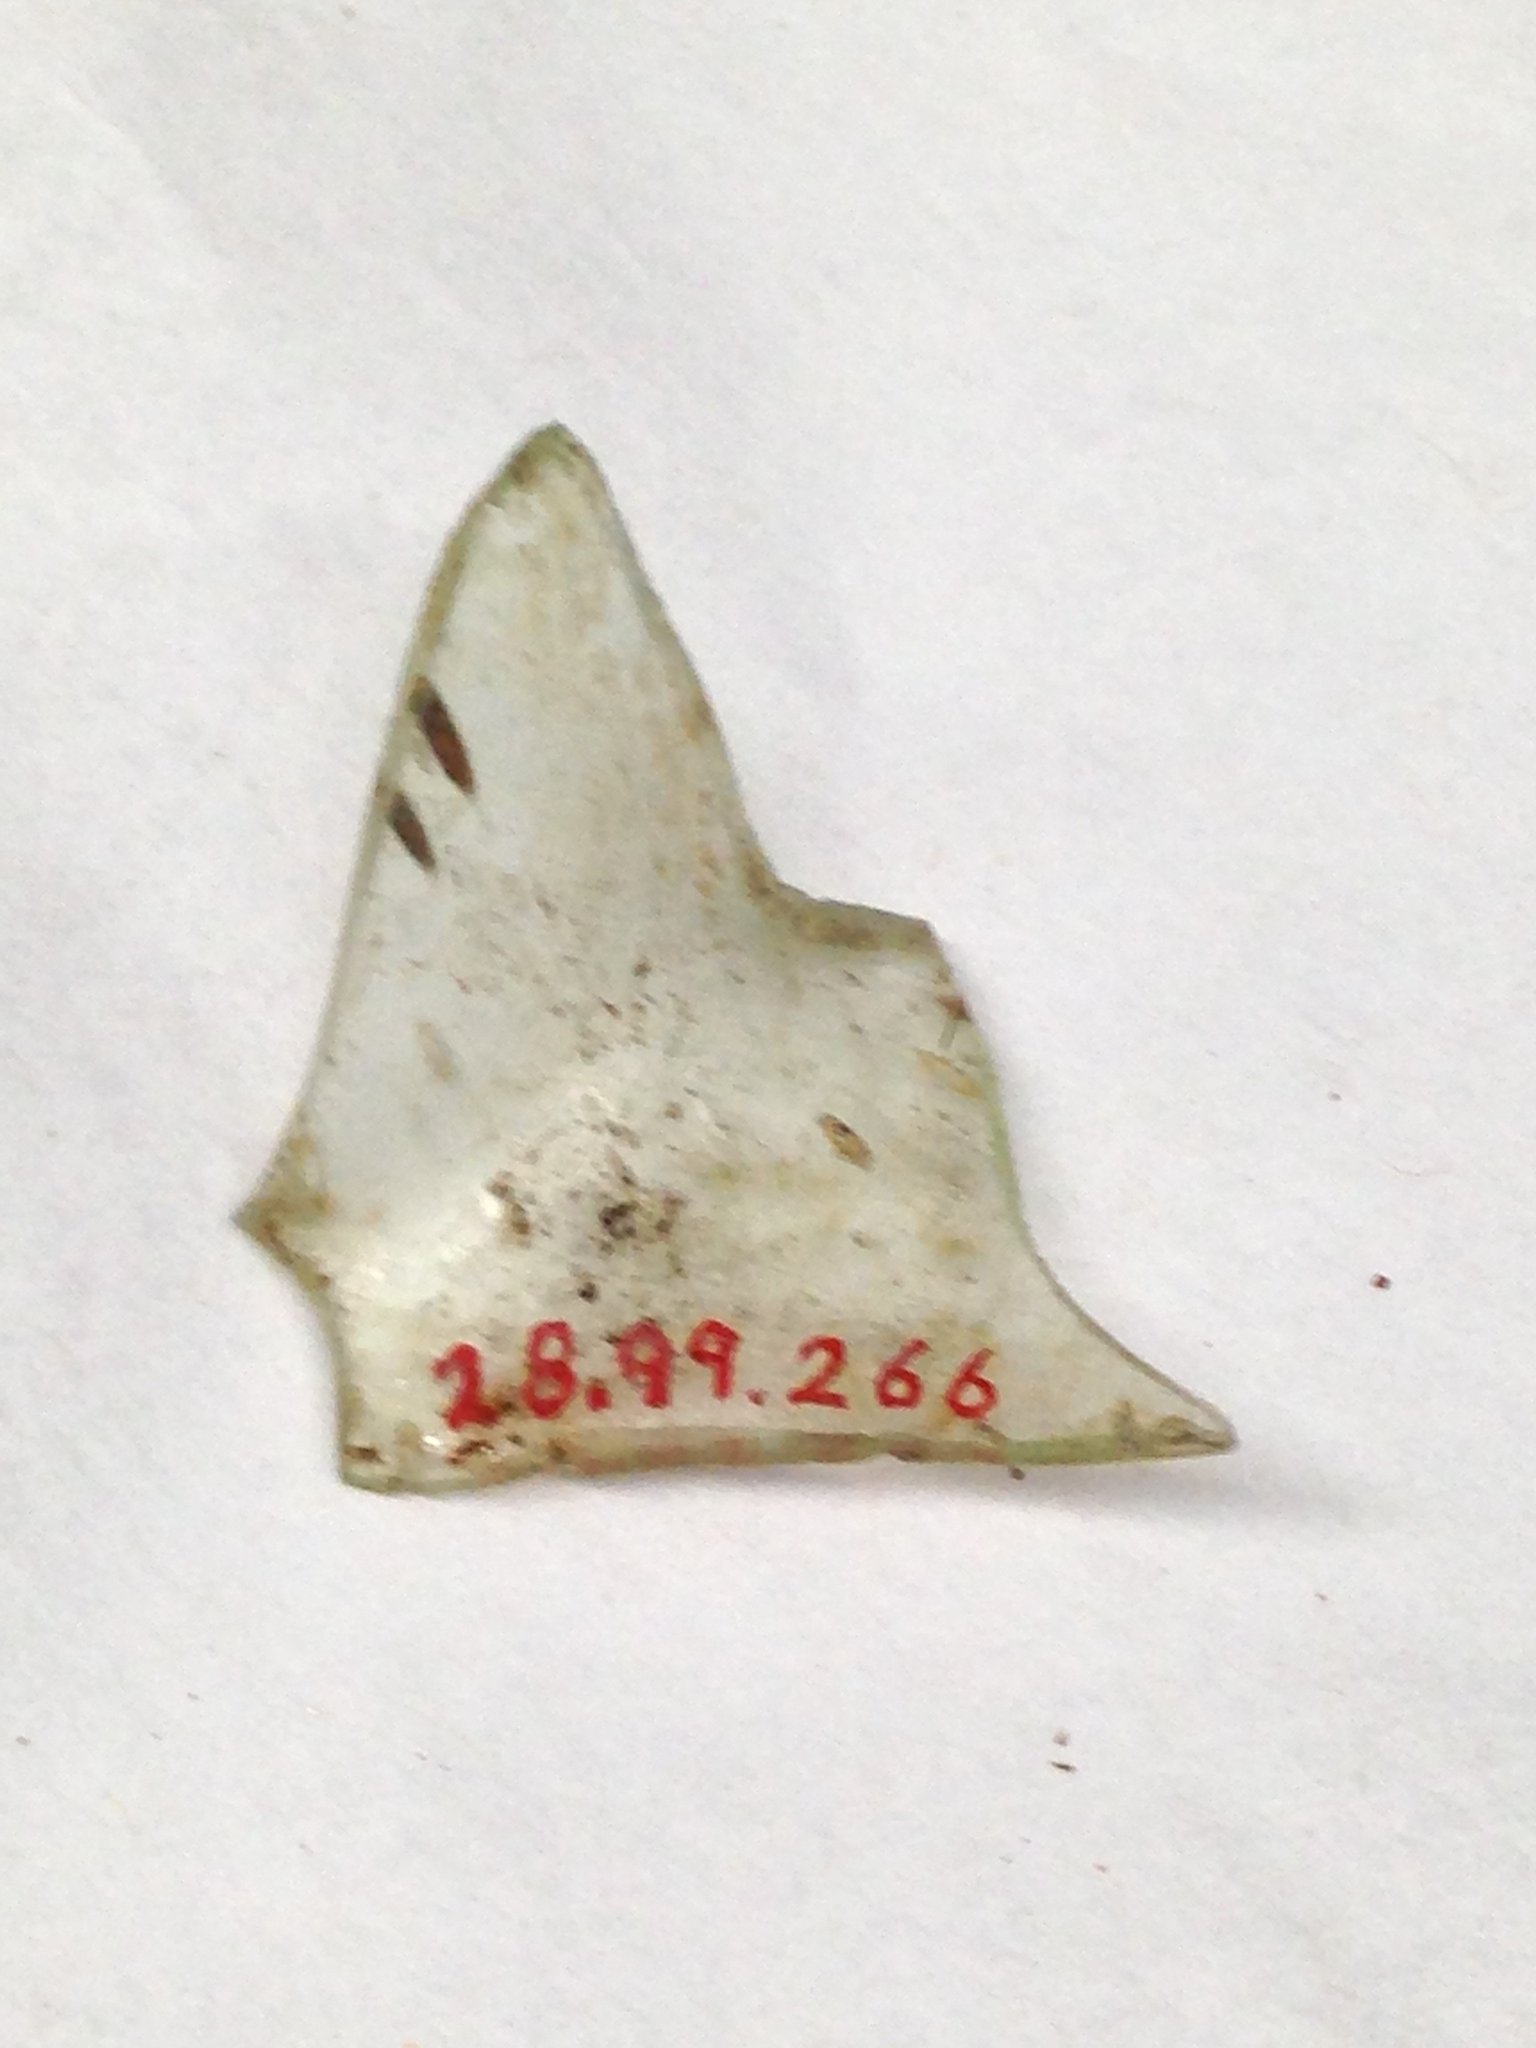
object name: fragment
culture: european or middle eastern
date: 1150-1250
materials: ceramic, glass